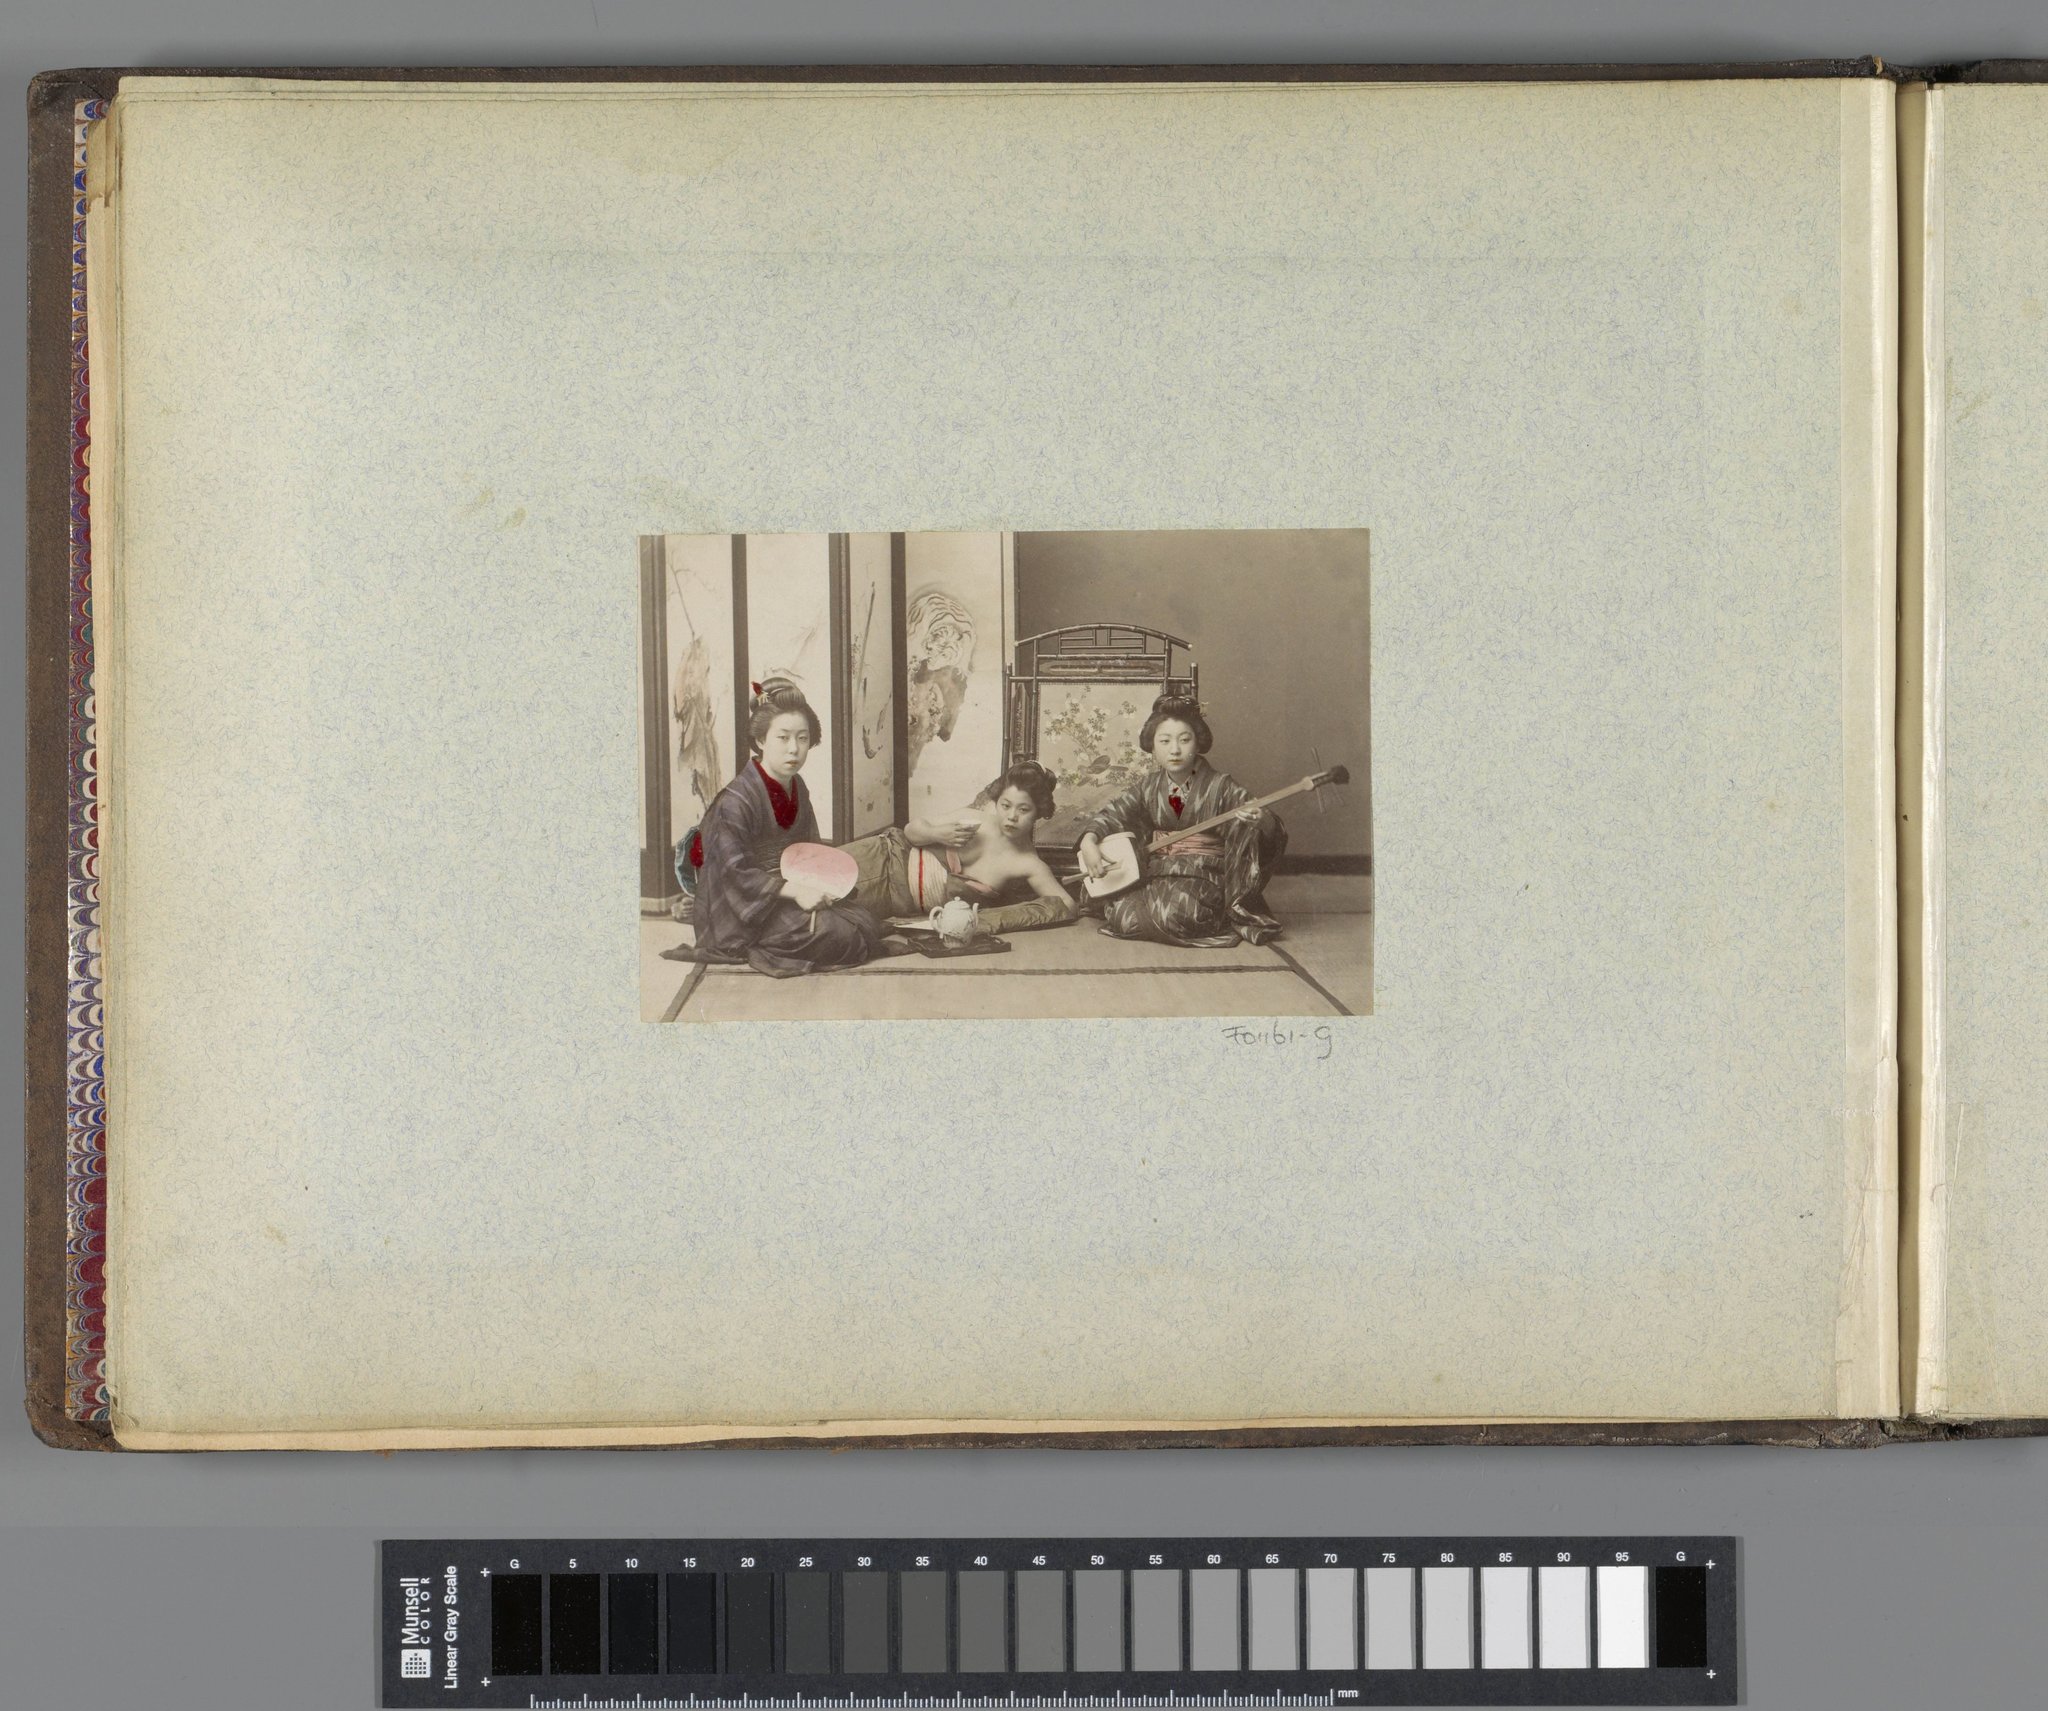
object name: photograph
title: Portret van drie Japanse vrouwen bij kamerschermen, met waaier, theeservies en snaarinstrument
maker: Anonymous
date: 1870-1891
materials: paper, photographic support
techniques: albumen print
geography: japan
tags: adult woman, making music; musician with instrument, fan, string instruments (plucked), screen, folding screen, tea- and coffee-service, japan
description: Onderdeel van Fotoalbum van een reis naar Manilla.